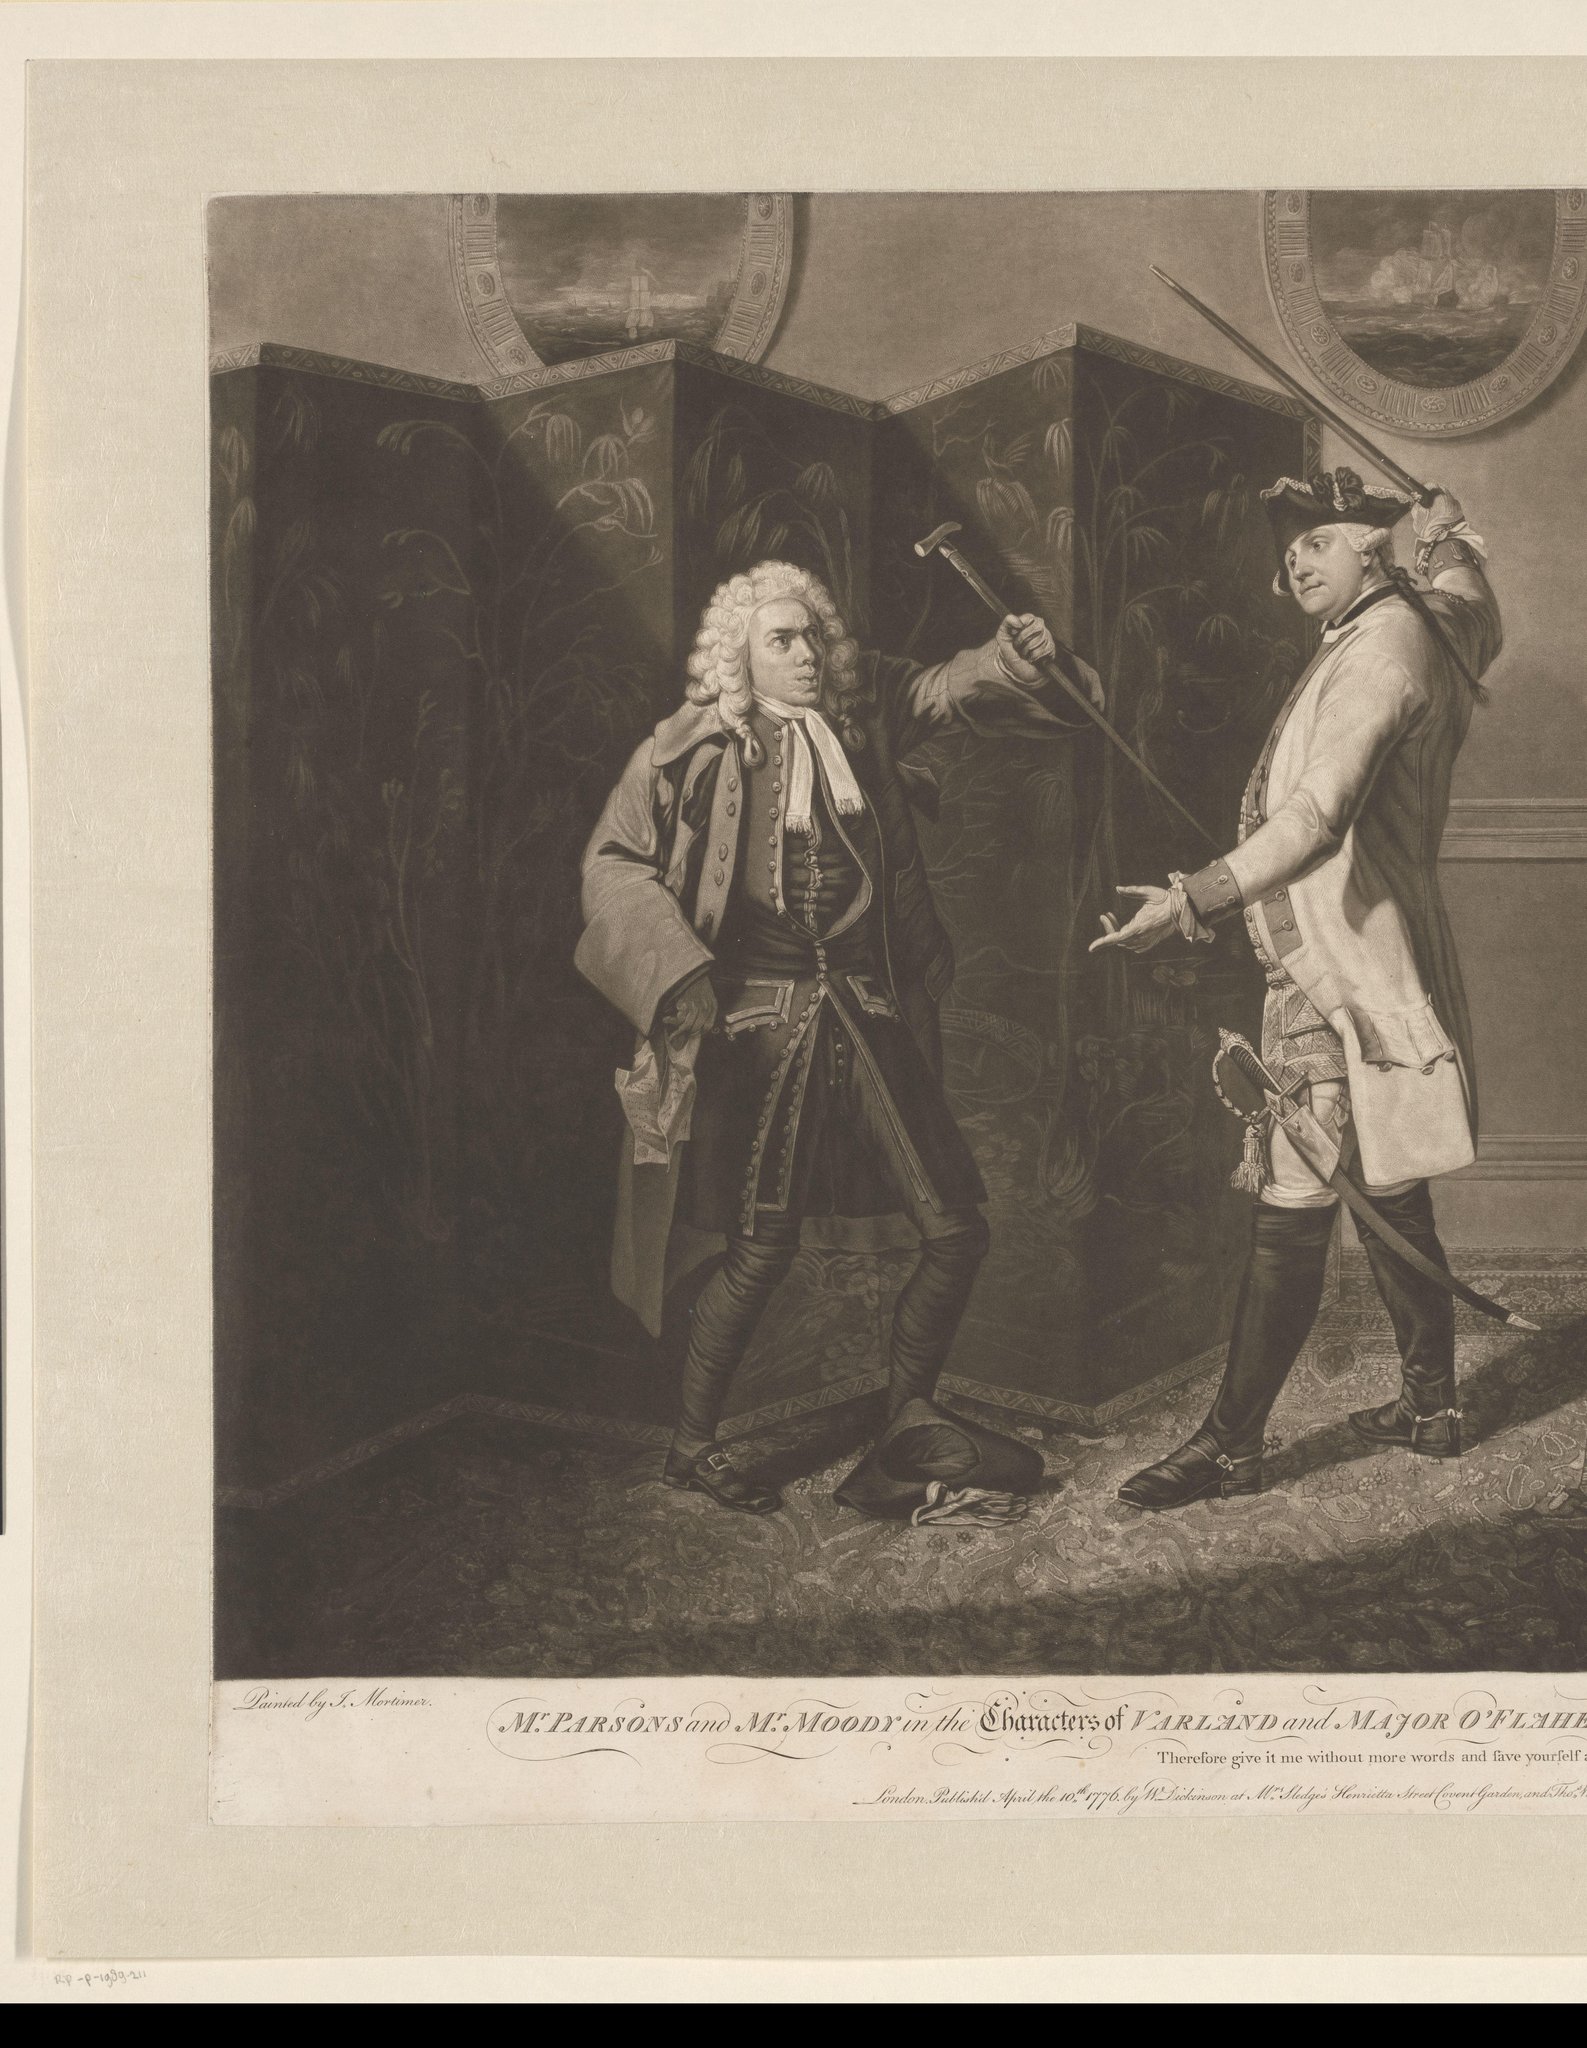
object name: print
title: Zelfportret van de kunstenaar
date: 1896-1897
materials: paper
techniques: lithography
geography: paris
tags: painter, draughtsman, paul cézanne, historical persons, portrait, self-portrait of painter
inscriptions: collector's mark: Lugt 2228a, collector's mark: Lugt 2760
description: In de jaren 1890 verzocht de kunsthandelaar Ambroise Vollard Cézanne enkele litho's te maken, waaronder een zelfportret. Het was zijn bedoeling de toen nog onbekende kunstenaar via dit medium grotere bekendheid te geven. Hoewel Cézanne zich niet aangetrokken voelde tot de grafische technieken voldeed hij aan dit verzoek en gaf zichzelf weer als schilder voor een doek.